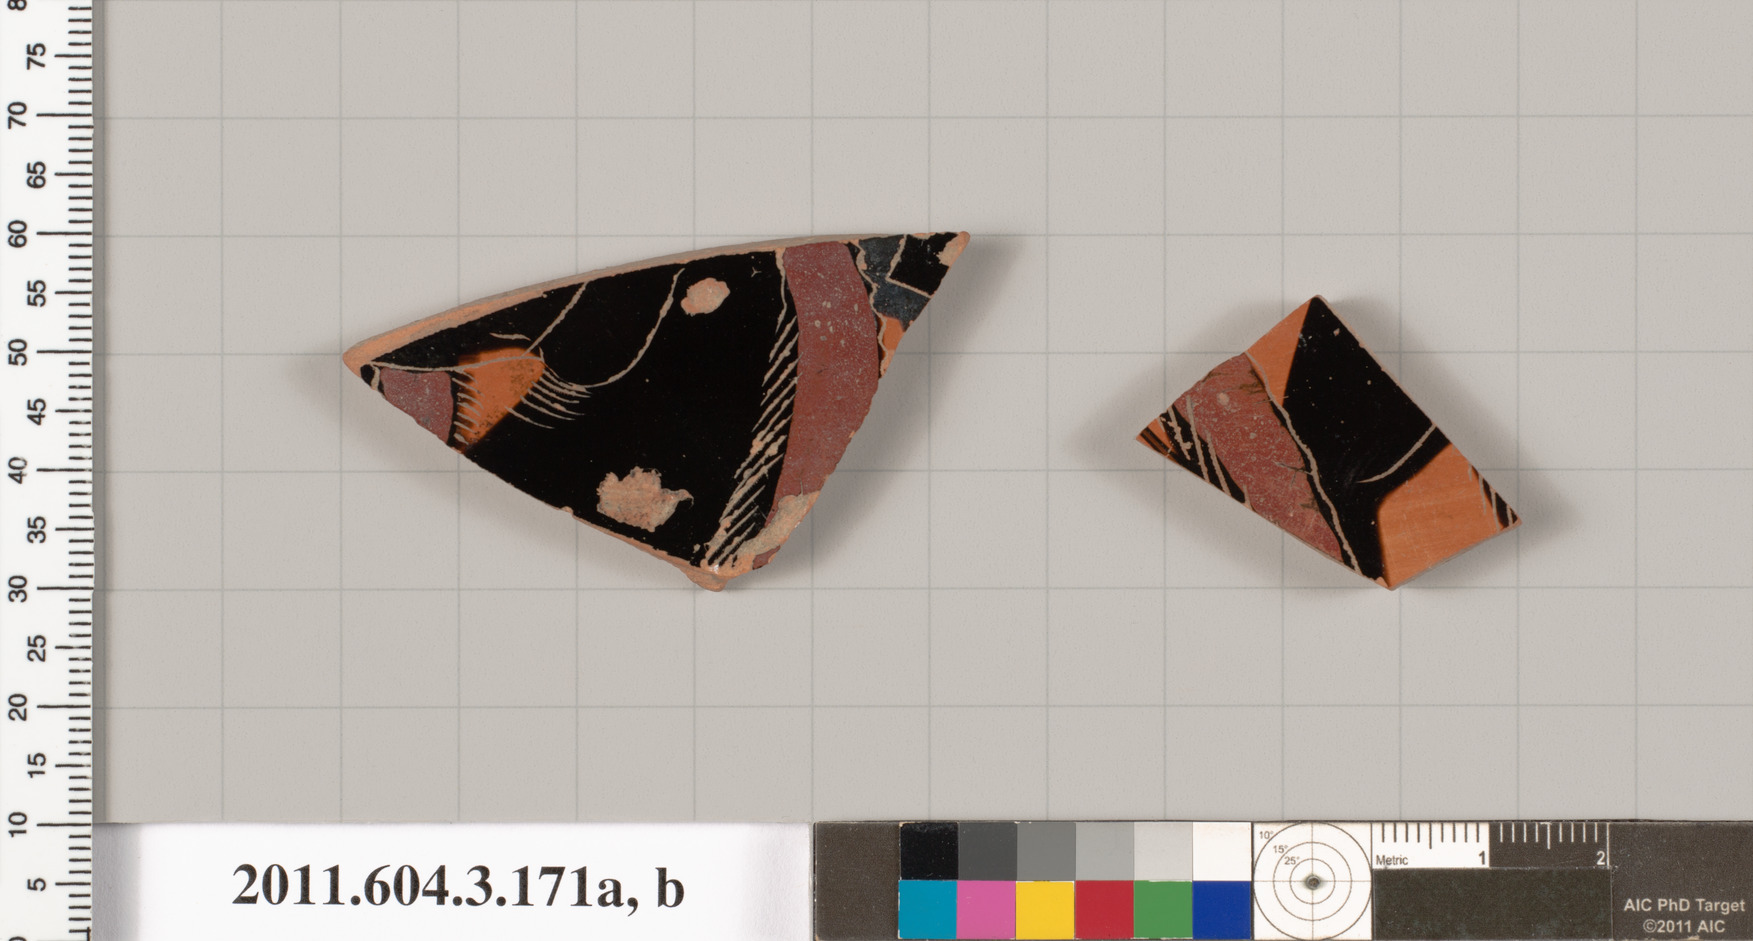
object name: amphora fragment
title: Terracotta fragments of an amphora (jar)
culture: greek, attic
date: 550-526 BCE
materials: terracotta